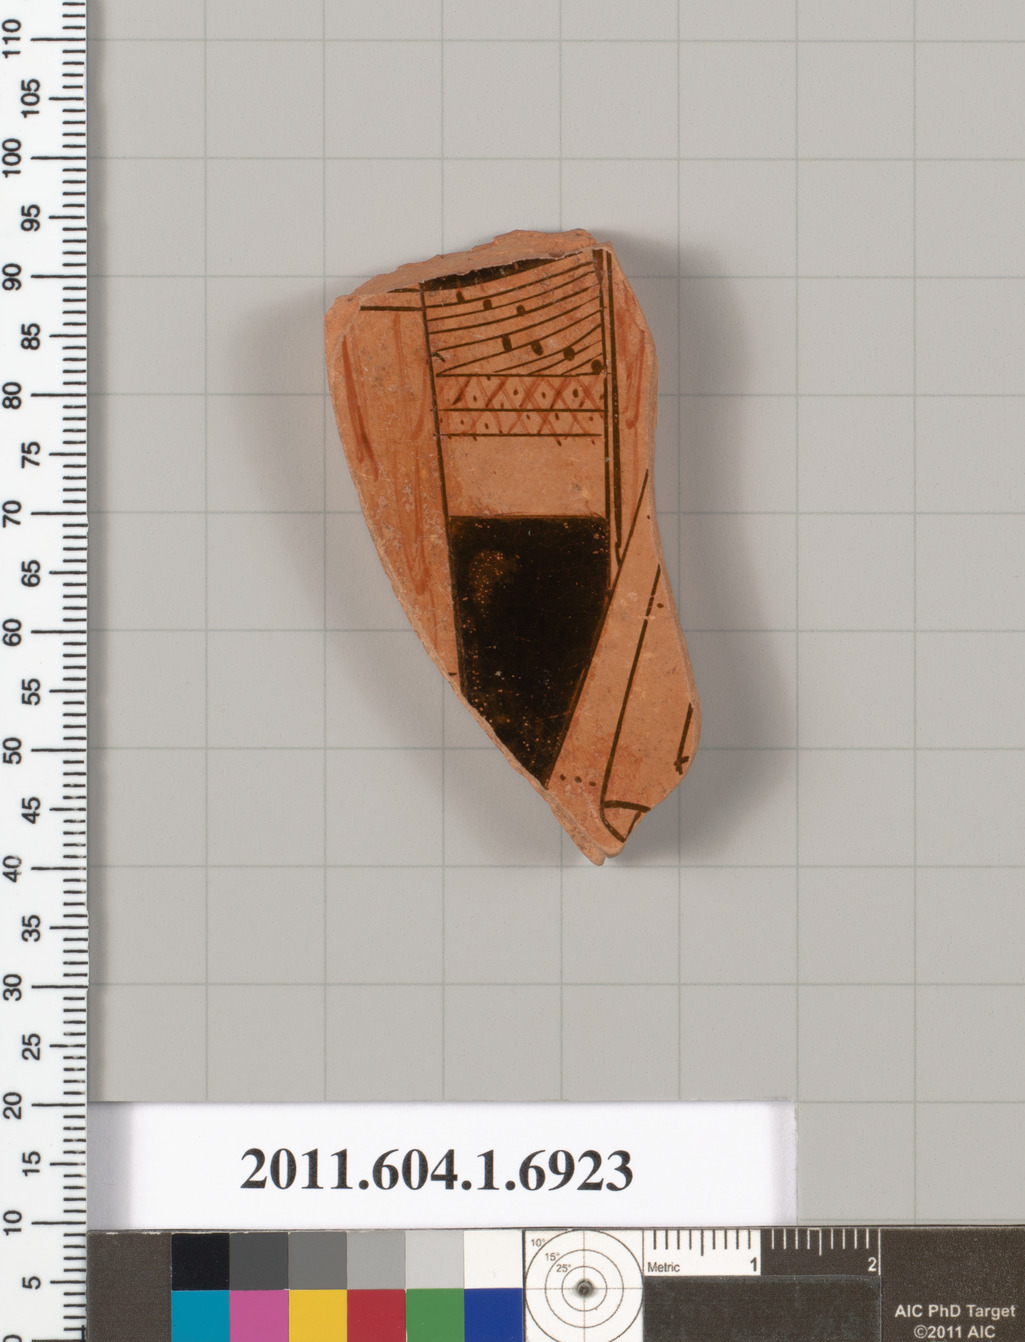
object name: kylix fragment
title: Terracotta fragment of a kylix (drinking cup)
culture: greek, attic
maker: brygan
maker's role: artist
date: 490-470 BCE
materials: terracotta